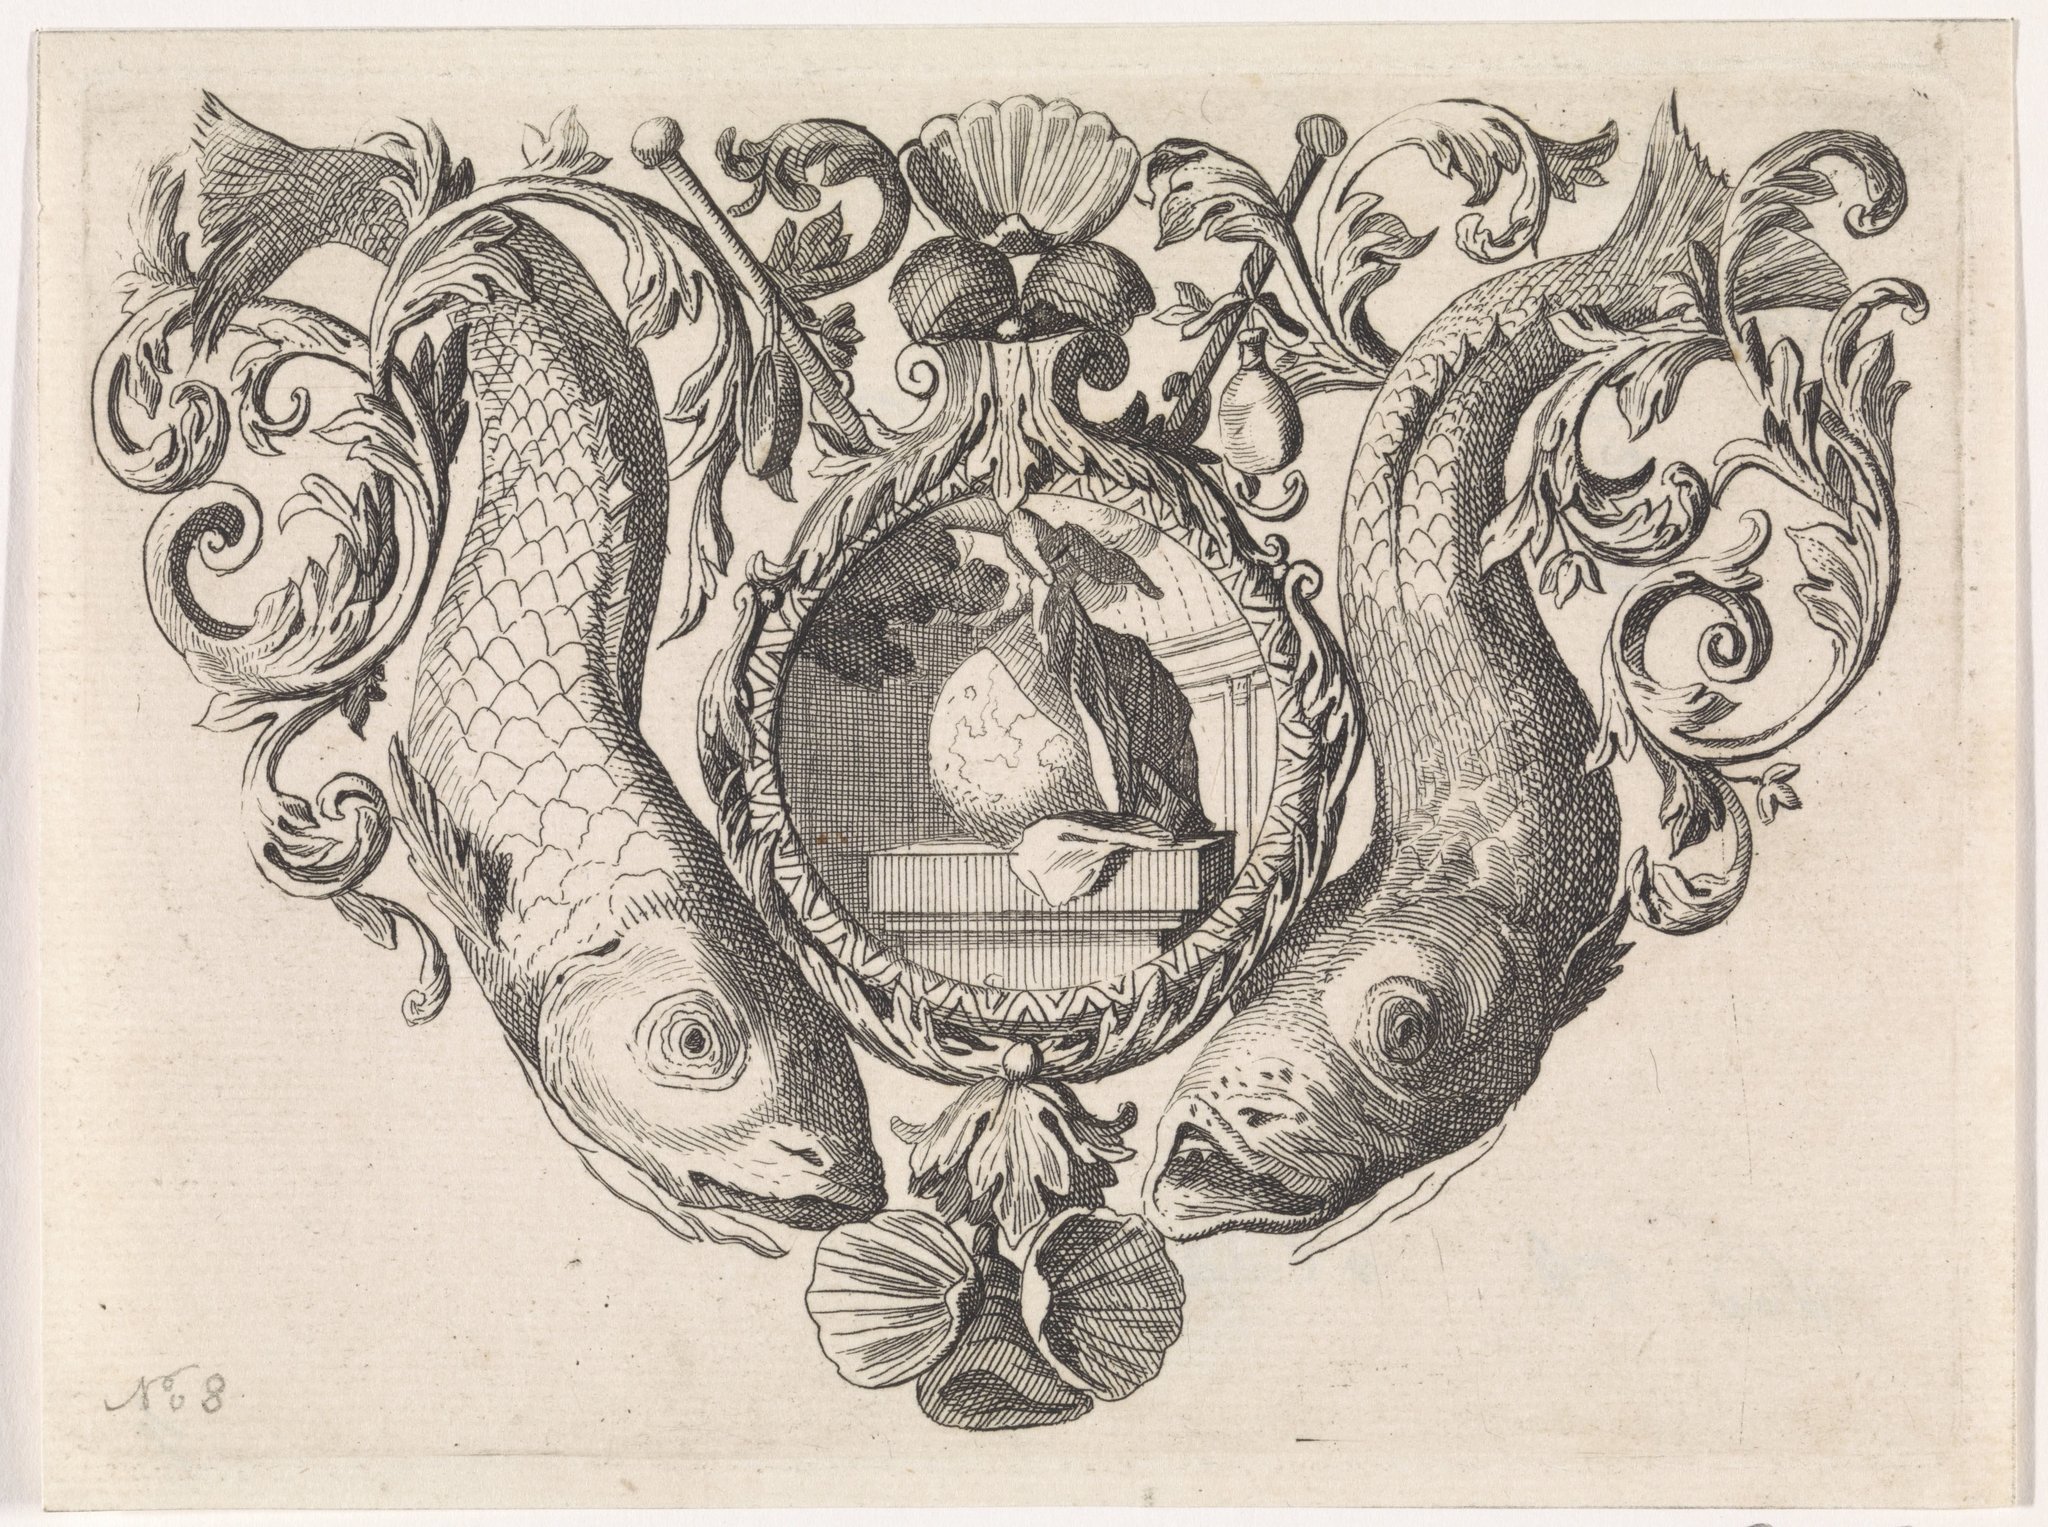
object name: book illustration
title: Onthulling van een globe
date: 1705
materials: paper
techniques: etching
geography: amsterdam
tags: fishes, globe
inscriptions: collector's mark: Lugt 2228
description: Illustratie uit: Basnage, Jacobus. 't Groot waerelds tafereel, waar in de heilige en waereldsche geschiedenissen en veranderingen zedert de schepping des waerelds tot het uiteinde van de Openbaring van Joannes, worden afgemaalt, 3 delen. Amsterdam: Jacob Lindenberg, 1705.